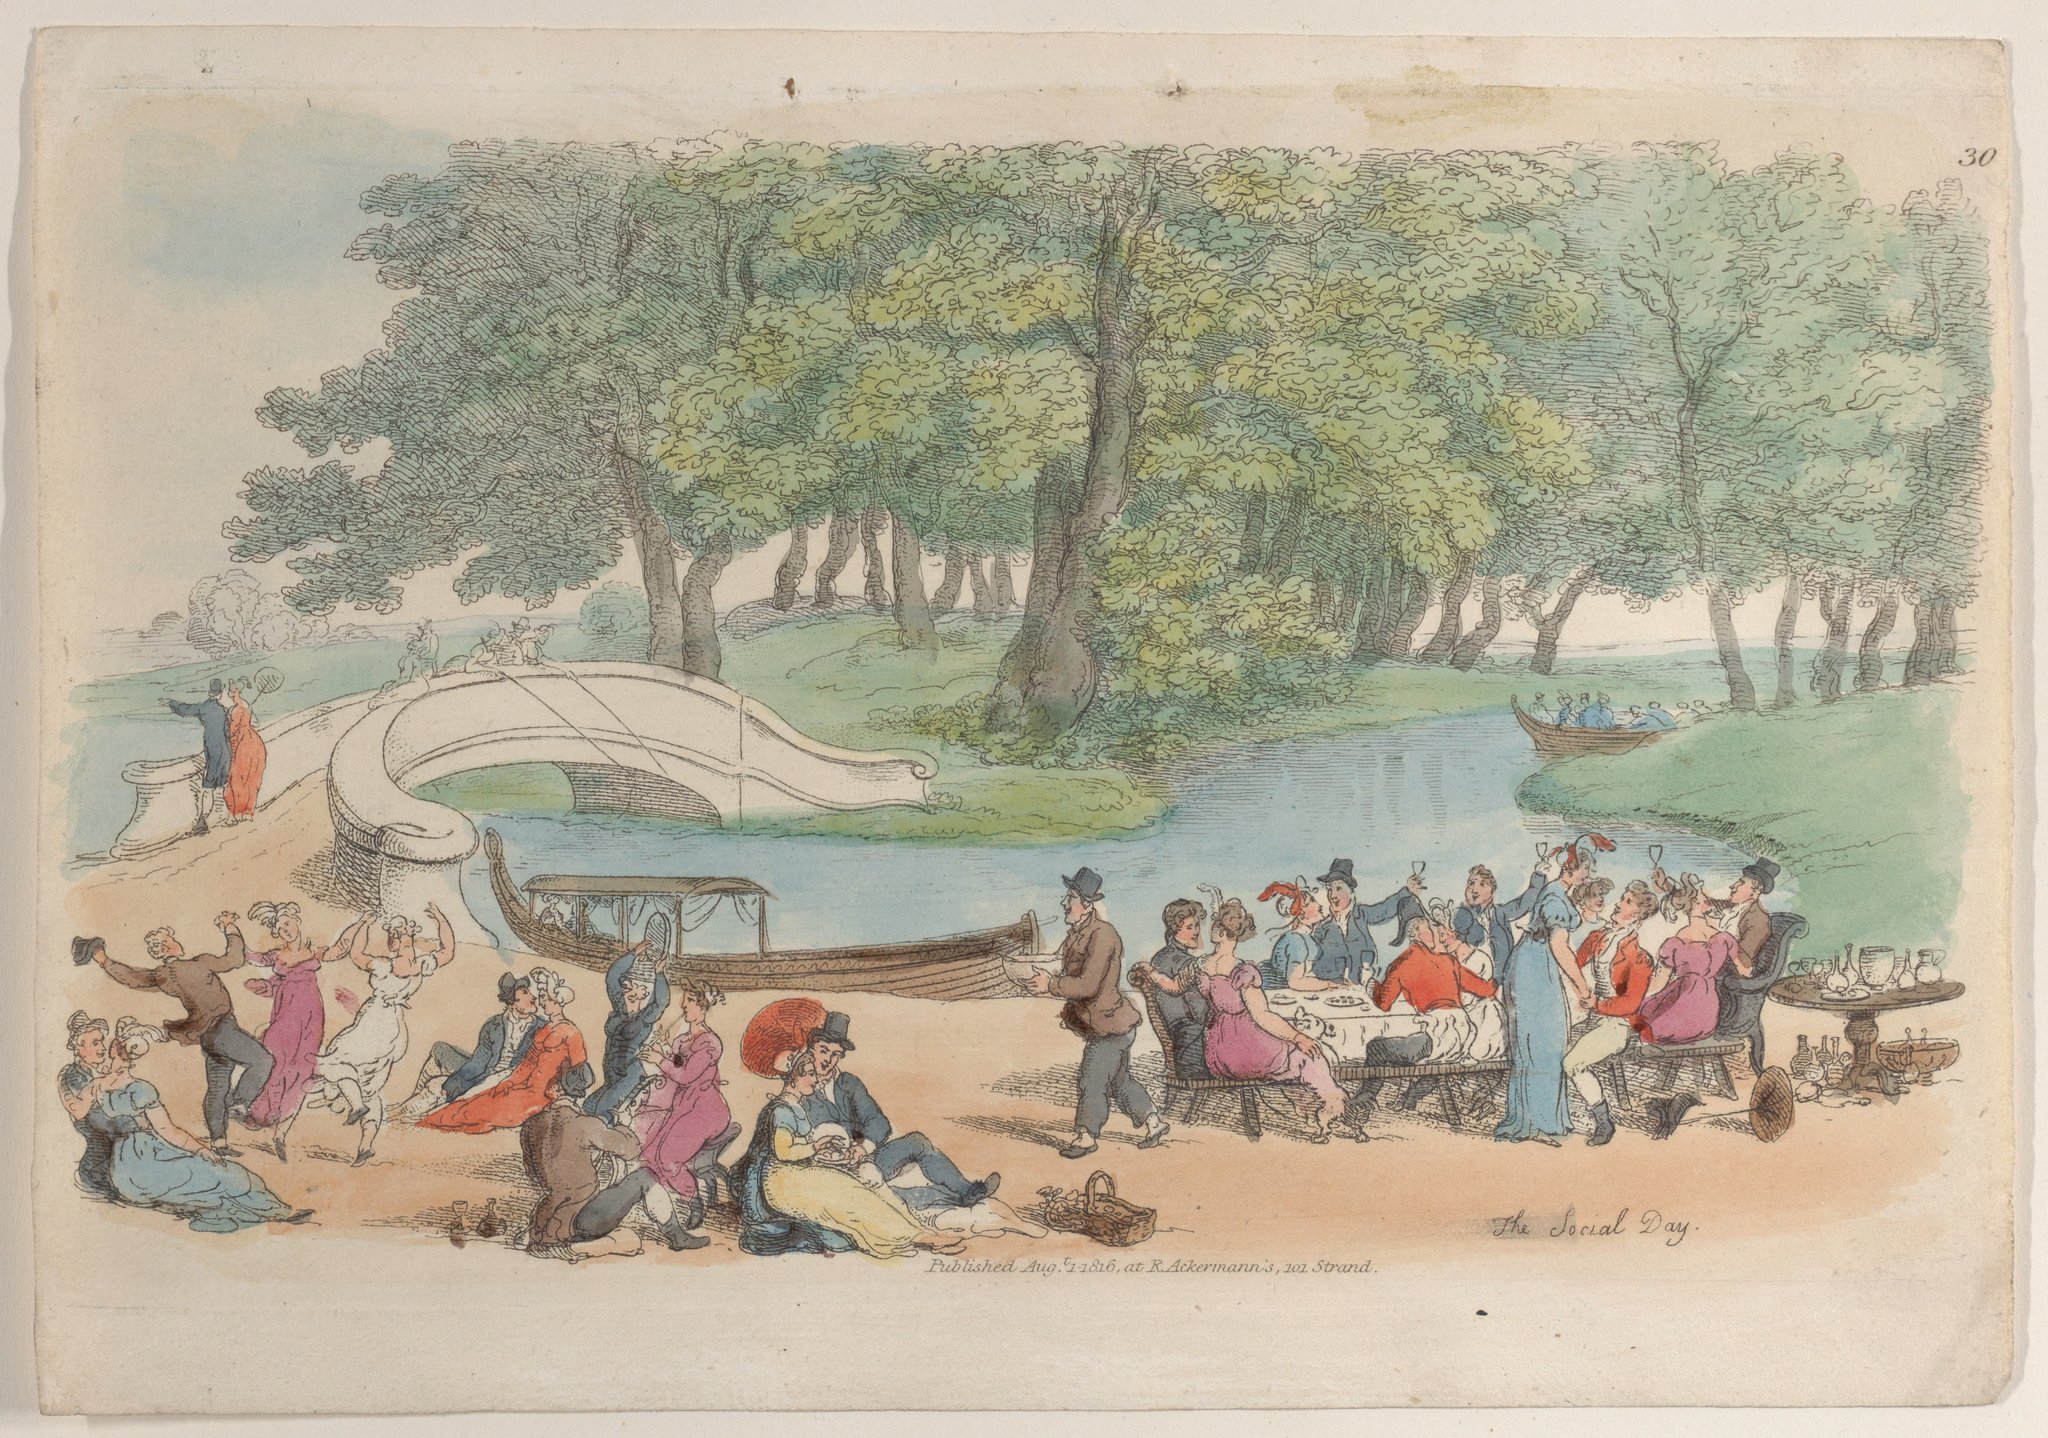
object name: print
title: Plate 30: The Social Day, from "World in Miniature"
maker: thomas rowlandson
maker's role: artist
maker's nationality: british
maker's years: 1757-1827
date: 1816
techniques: etching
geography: london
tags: men,women,dancing,rivers,drinking